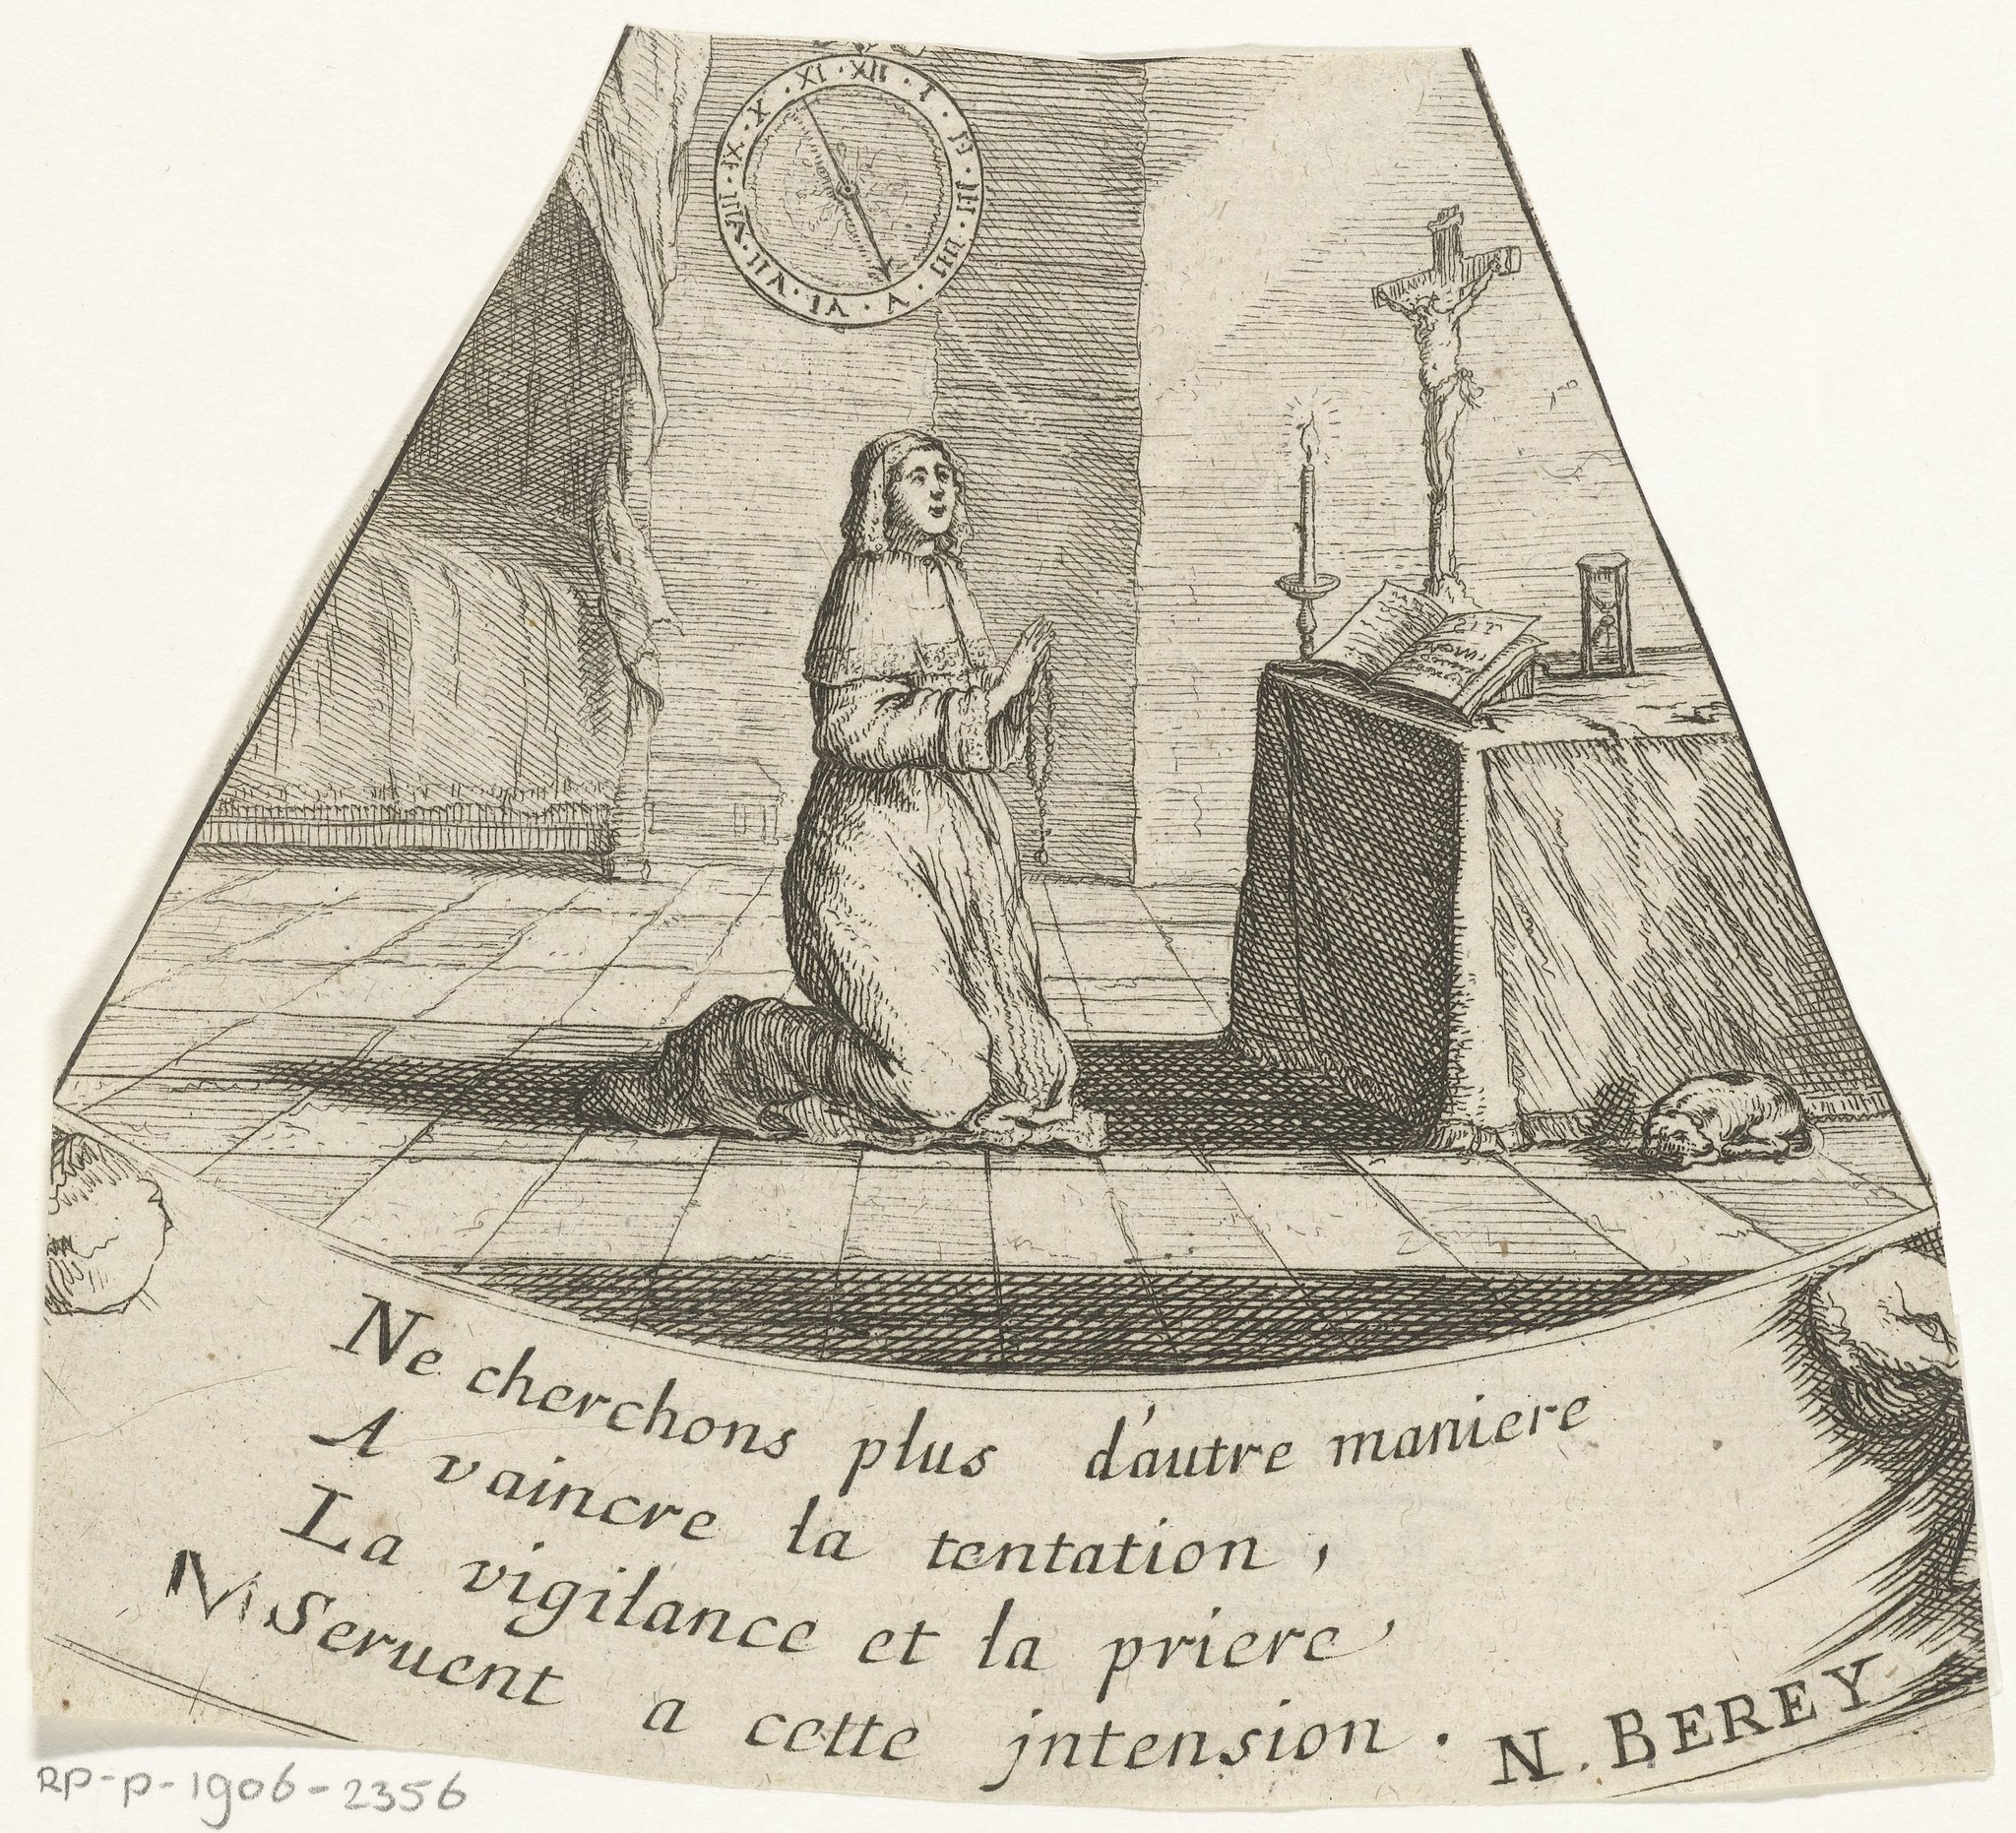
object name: print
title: Zeven werken van barmhartigheid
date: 1648-1665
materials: paper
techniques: etching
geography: paris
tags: praying for the living and the dead ~ one of the (seven) spiritual acts of mercy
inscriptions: collector's mark: Lugt 2228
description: Een vrouw zit geknield met een rozenkrans in haar handen voor een tafel met een crucifix. Naast de tafel slaapt een hond. Op de achtergrond een bed en een klok. Onder de voorstelling een Frans vers van vier regels. Zeshoekig blad, waarschijnlijk onderdeel van een cirkelvormige prent.